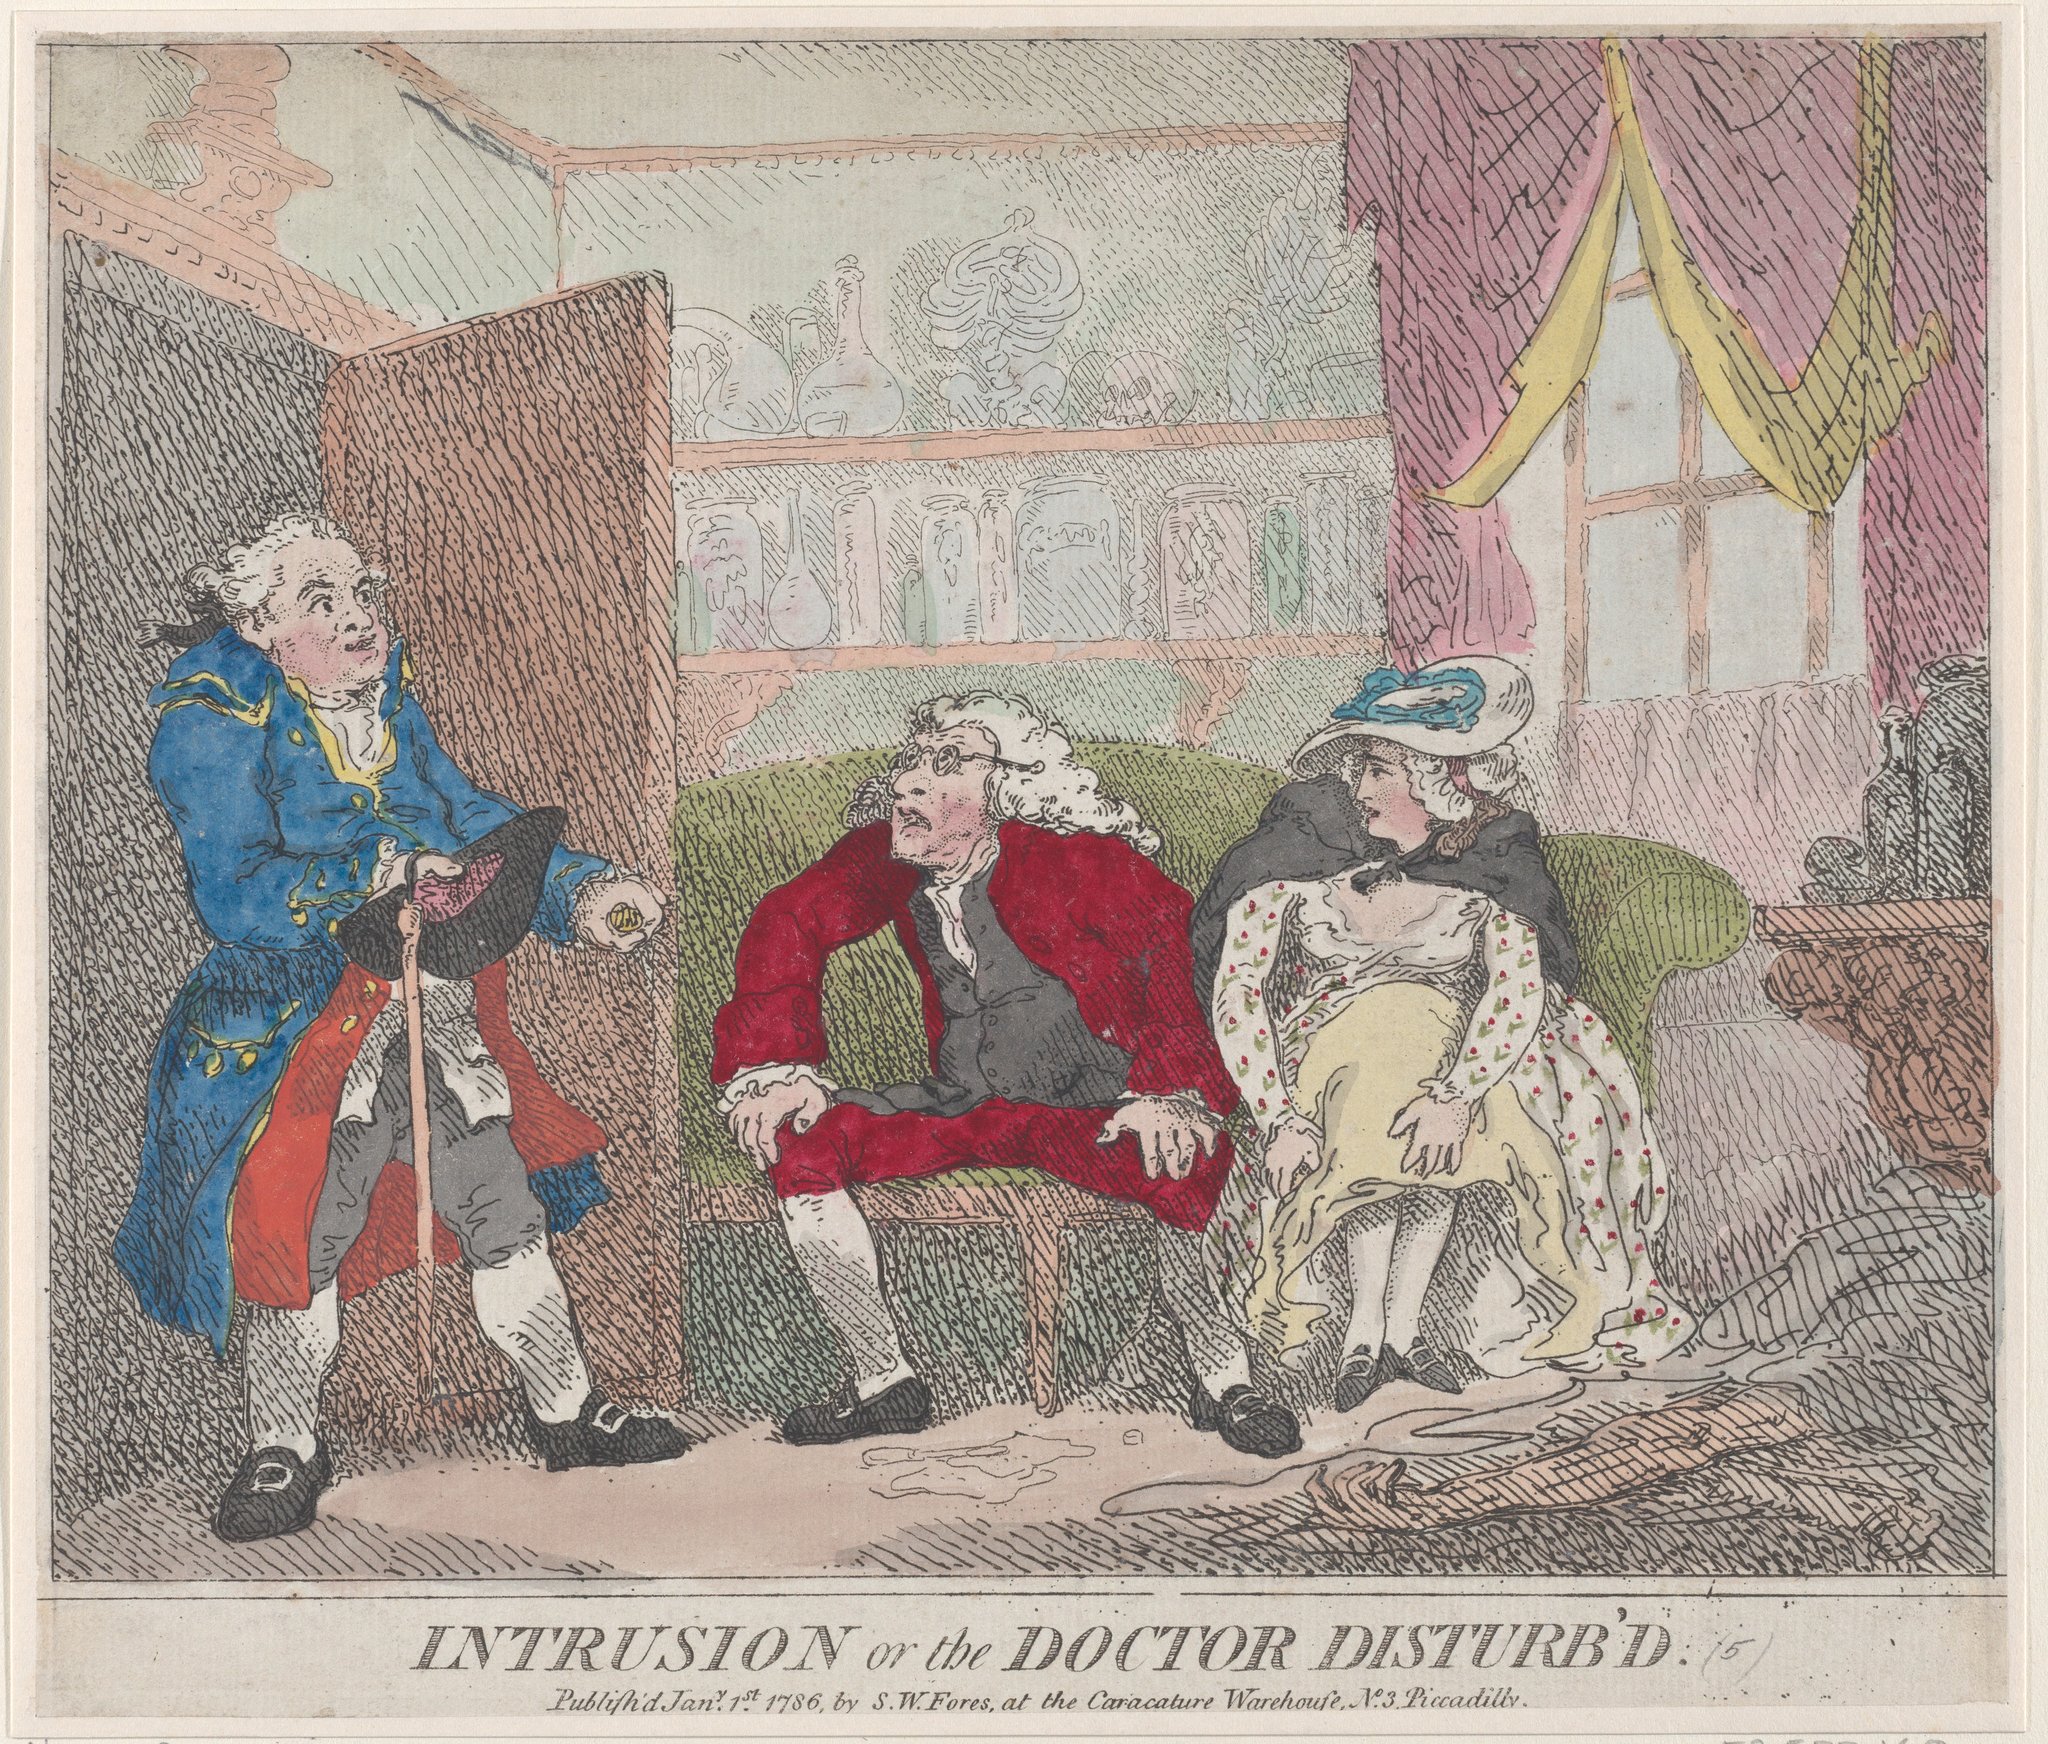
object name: print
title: Intrusion, or The Doctor Disturb'd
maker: thomas rowlandson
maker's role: artist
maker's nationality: british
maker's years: 1757-1827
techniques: etching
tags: satire,men,women